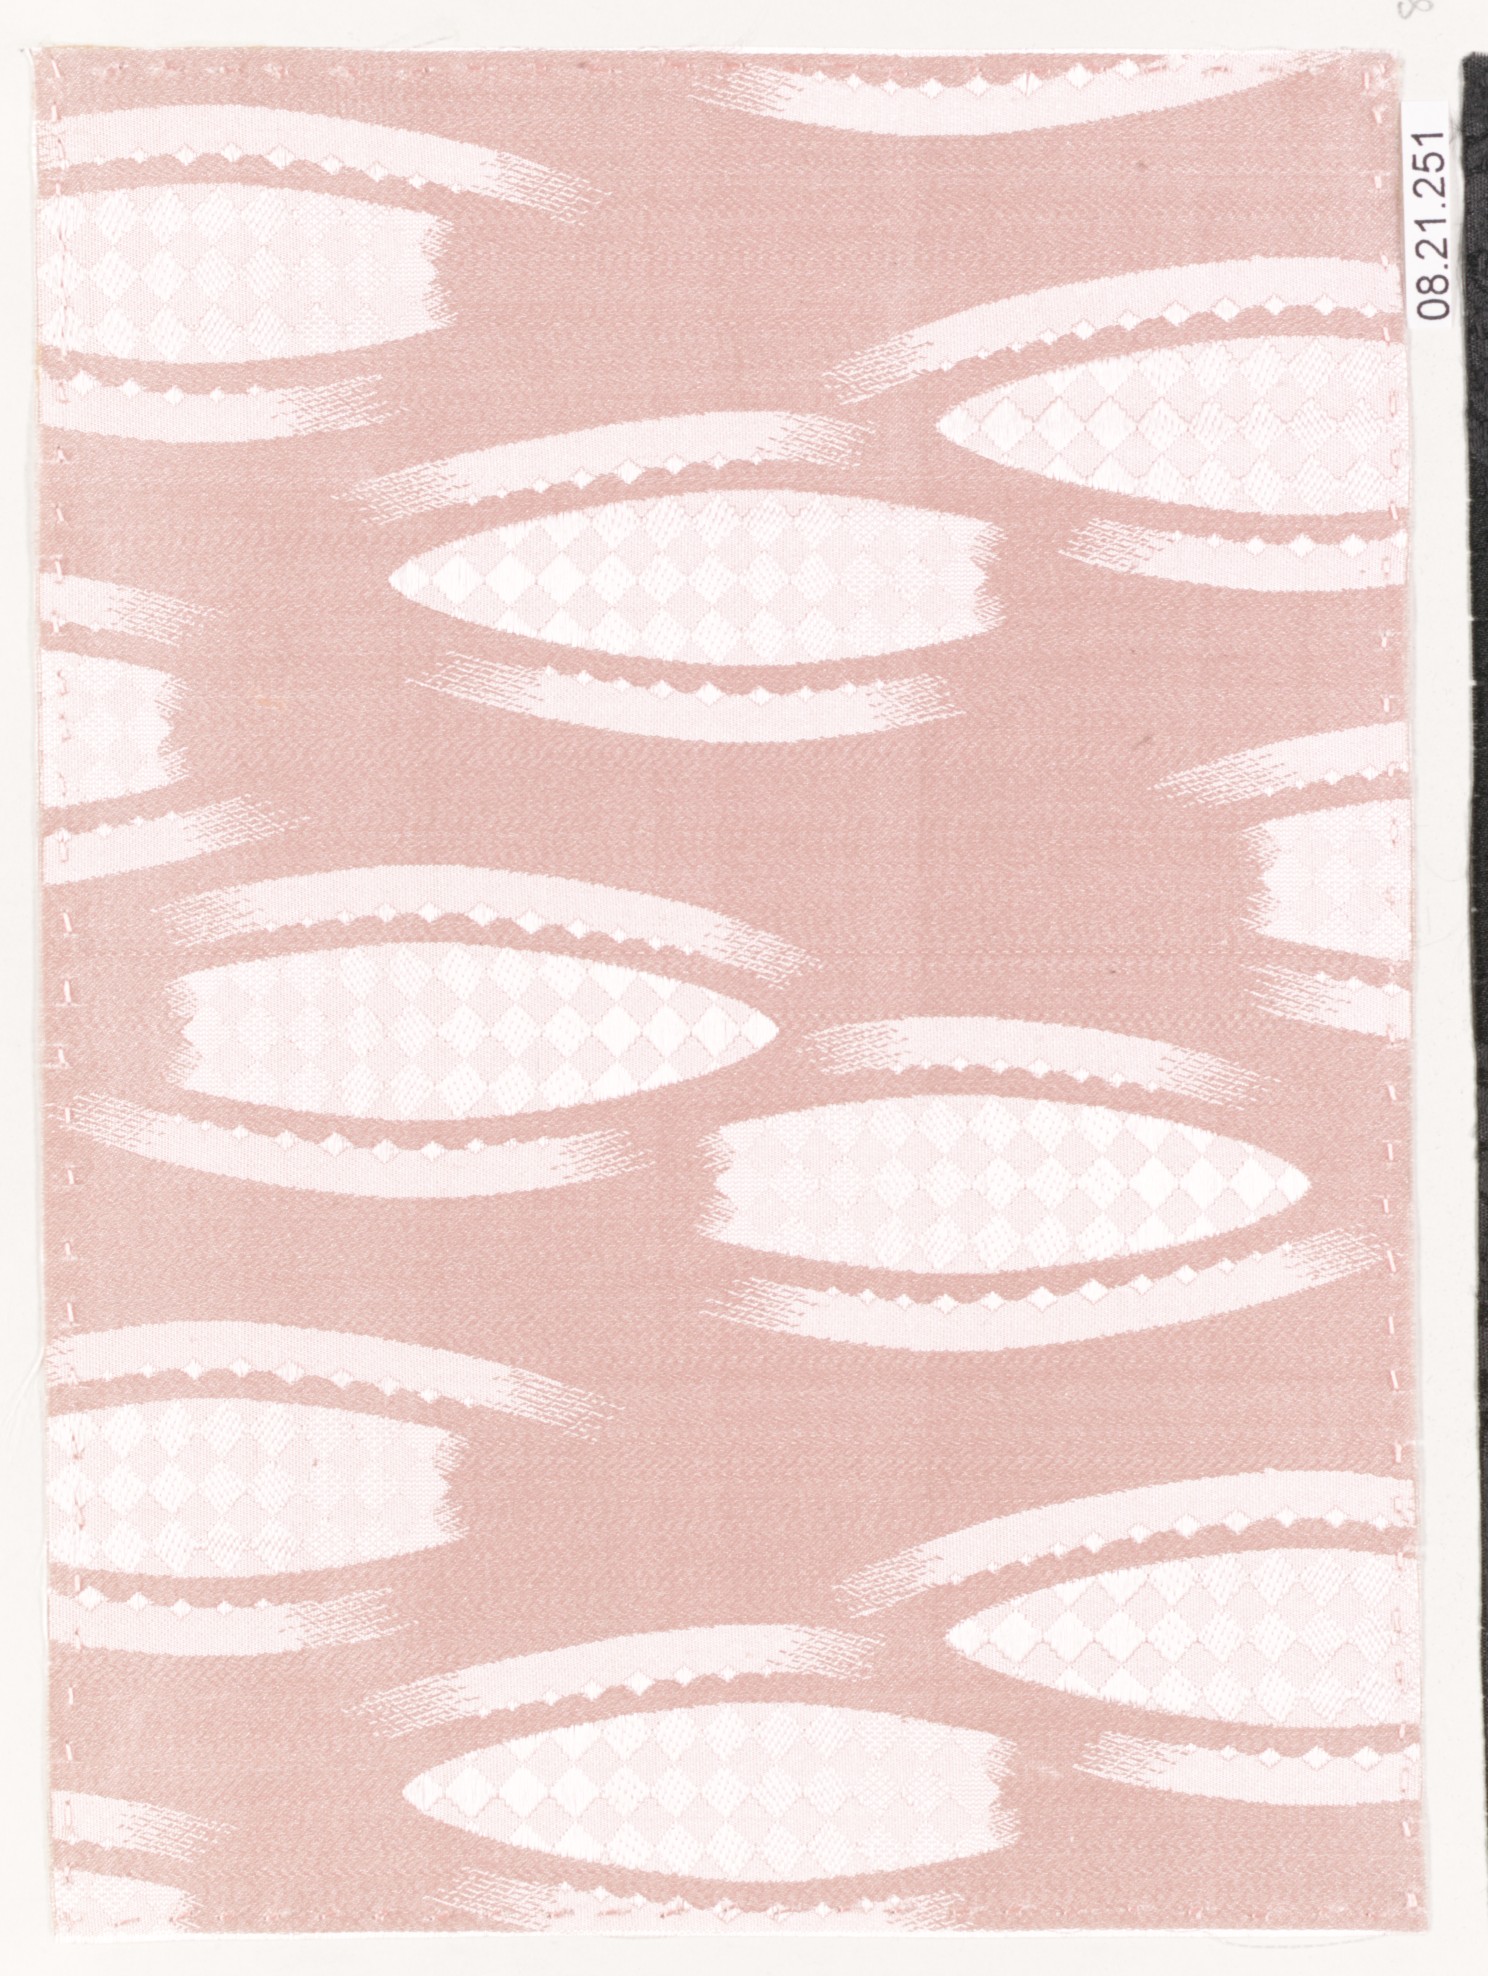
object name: textile sample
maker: Anonymous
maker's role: designer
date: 1900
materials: silk